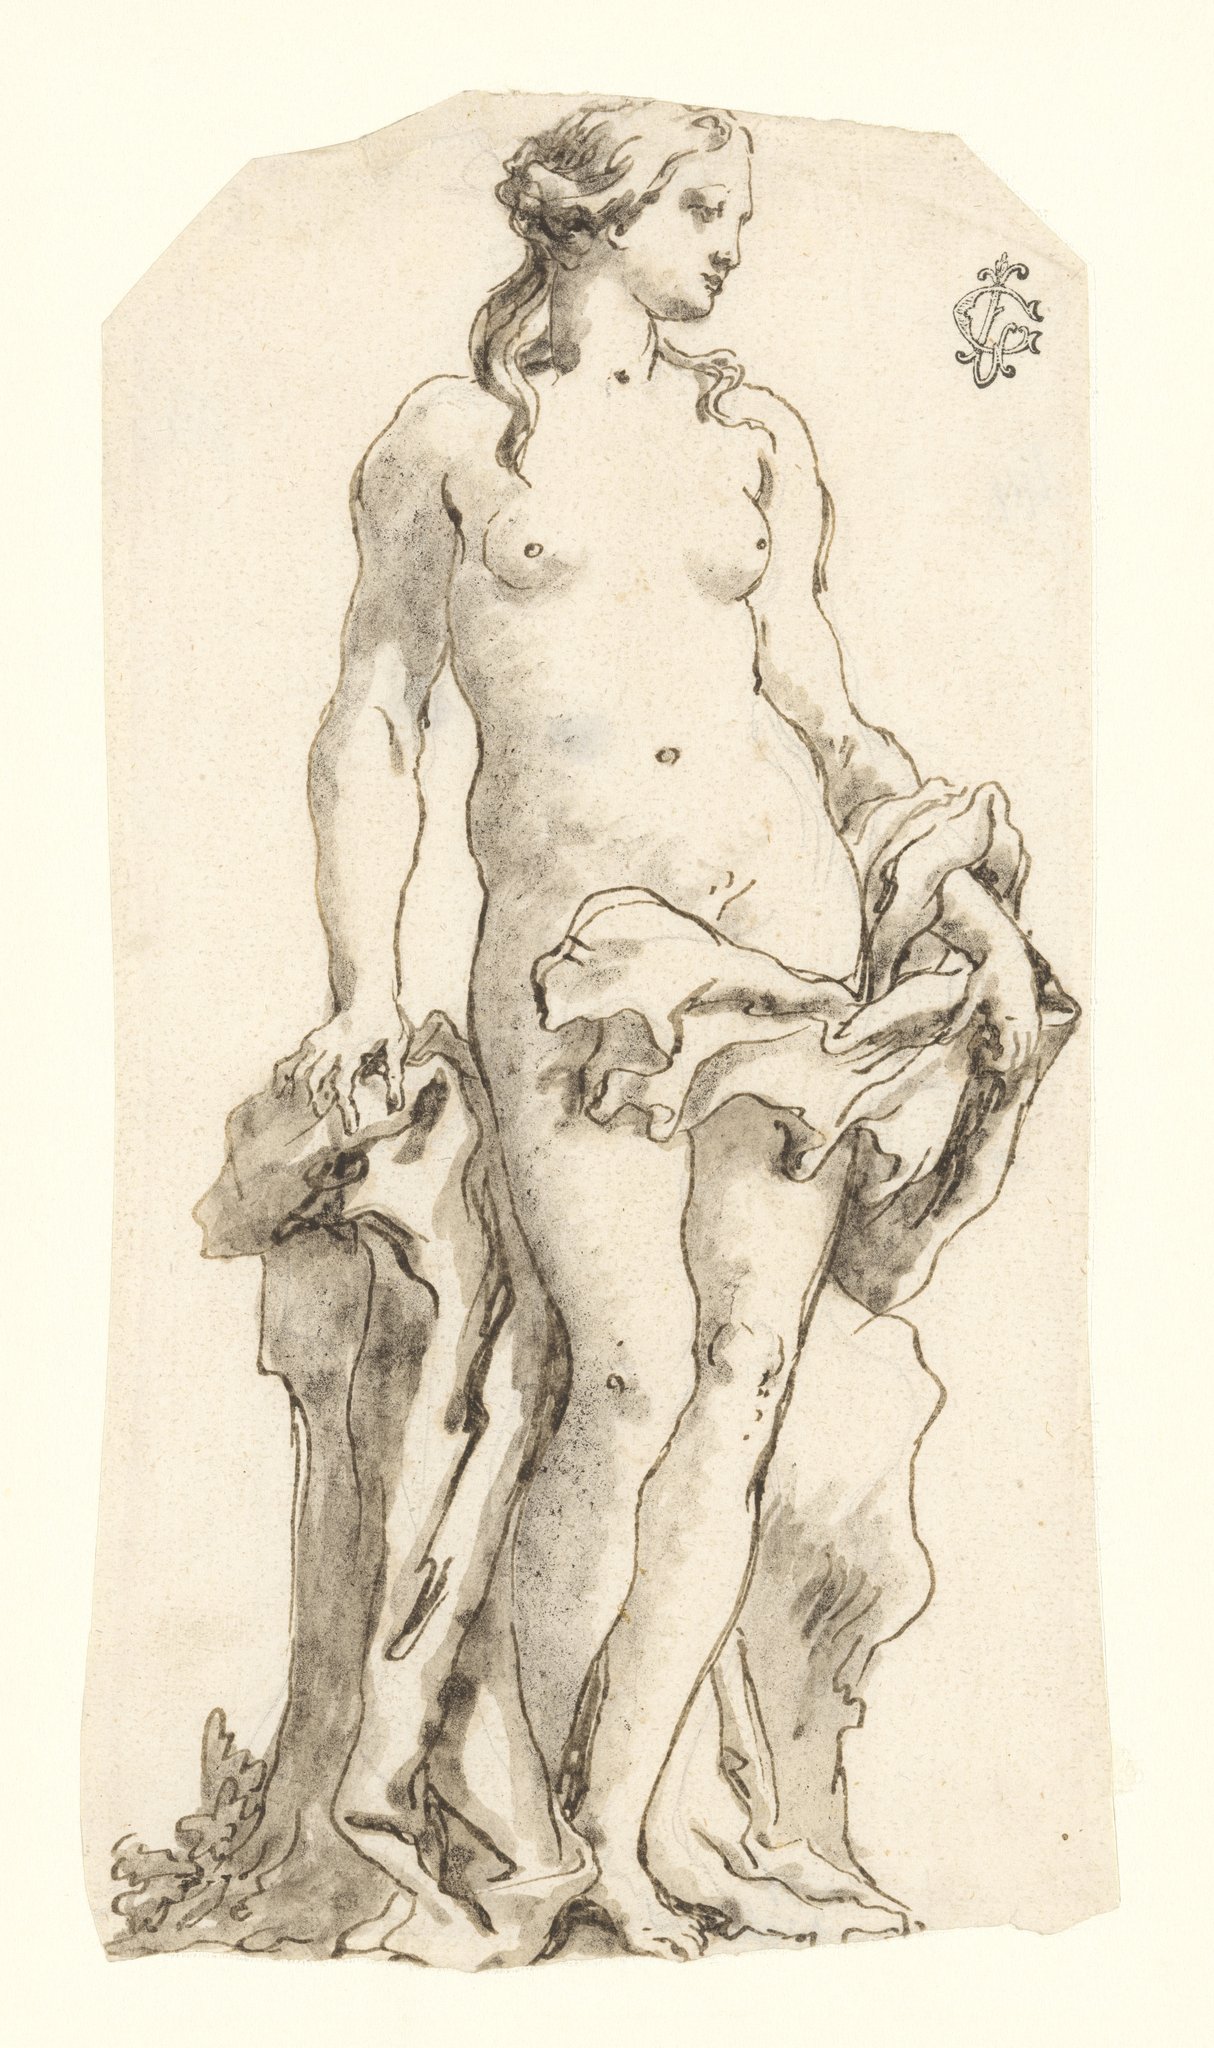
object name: drawing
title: Venus (?)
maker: giovanni domenico tiepolo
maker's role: artist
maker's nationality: italian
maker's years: 1727-1804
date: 1734-1833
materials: chalk, ink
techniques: pen, wash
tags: venus